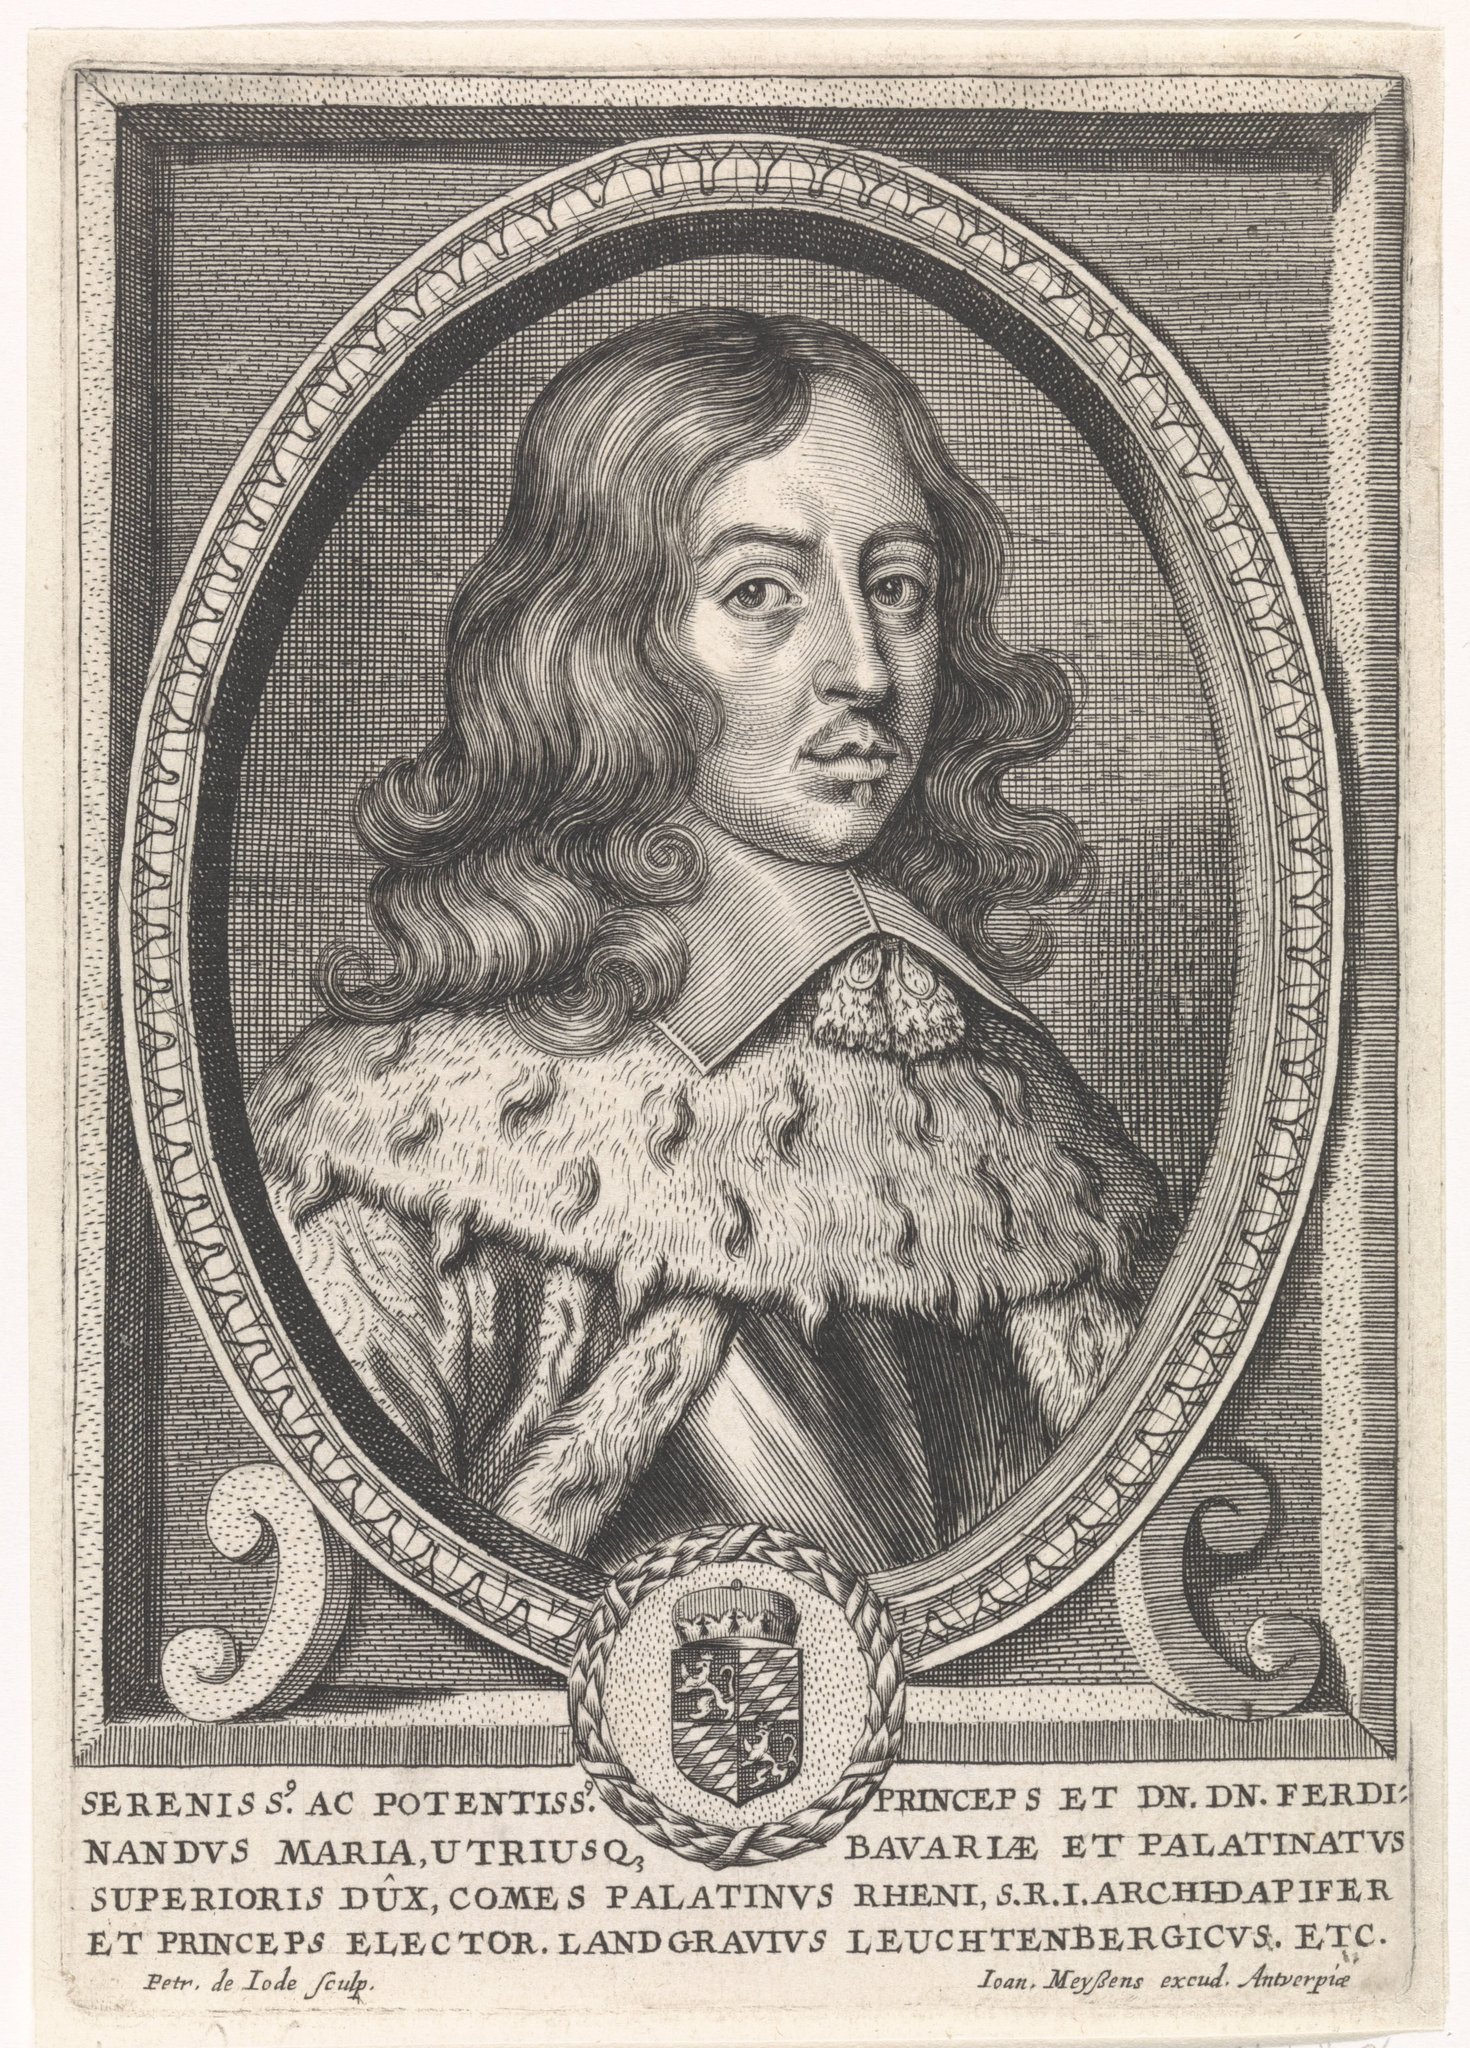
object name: print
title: Portret van Ferdinand Maria van Beieren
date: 1628-1670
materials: paper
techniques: engraving, etching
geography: antwerp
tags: ferdinand maria keurvorst van beieren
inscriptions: collector's mark: Lugt 2228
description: Busteportret van Ferdinand Maria van Beieren, in mantel. Het portret is gevat in een ovale omlijsting met vierkant randwerk met zijn wapenschild in een medaillon. In de marge een vierregelig onderschrift in het Latijn.